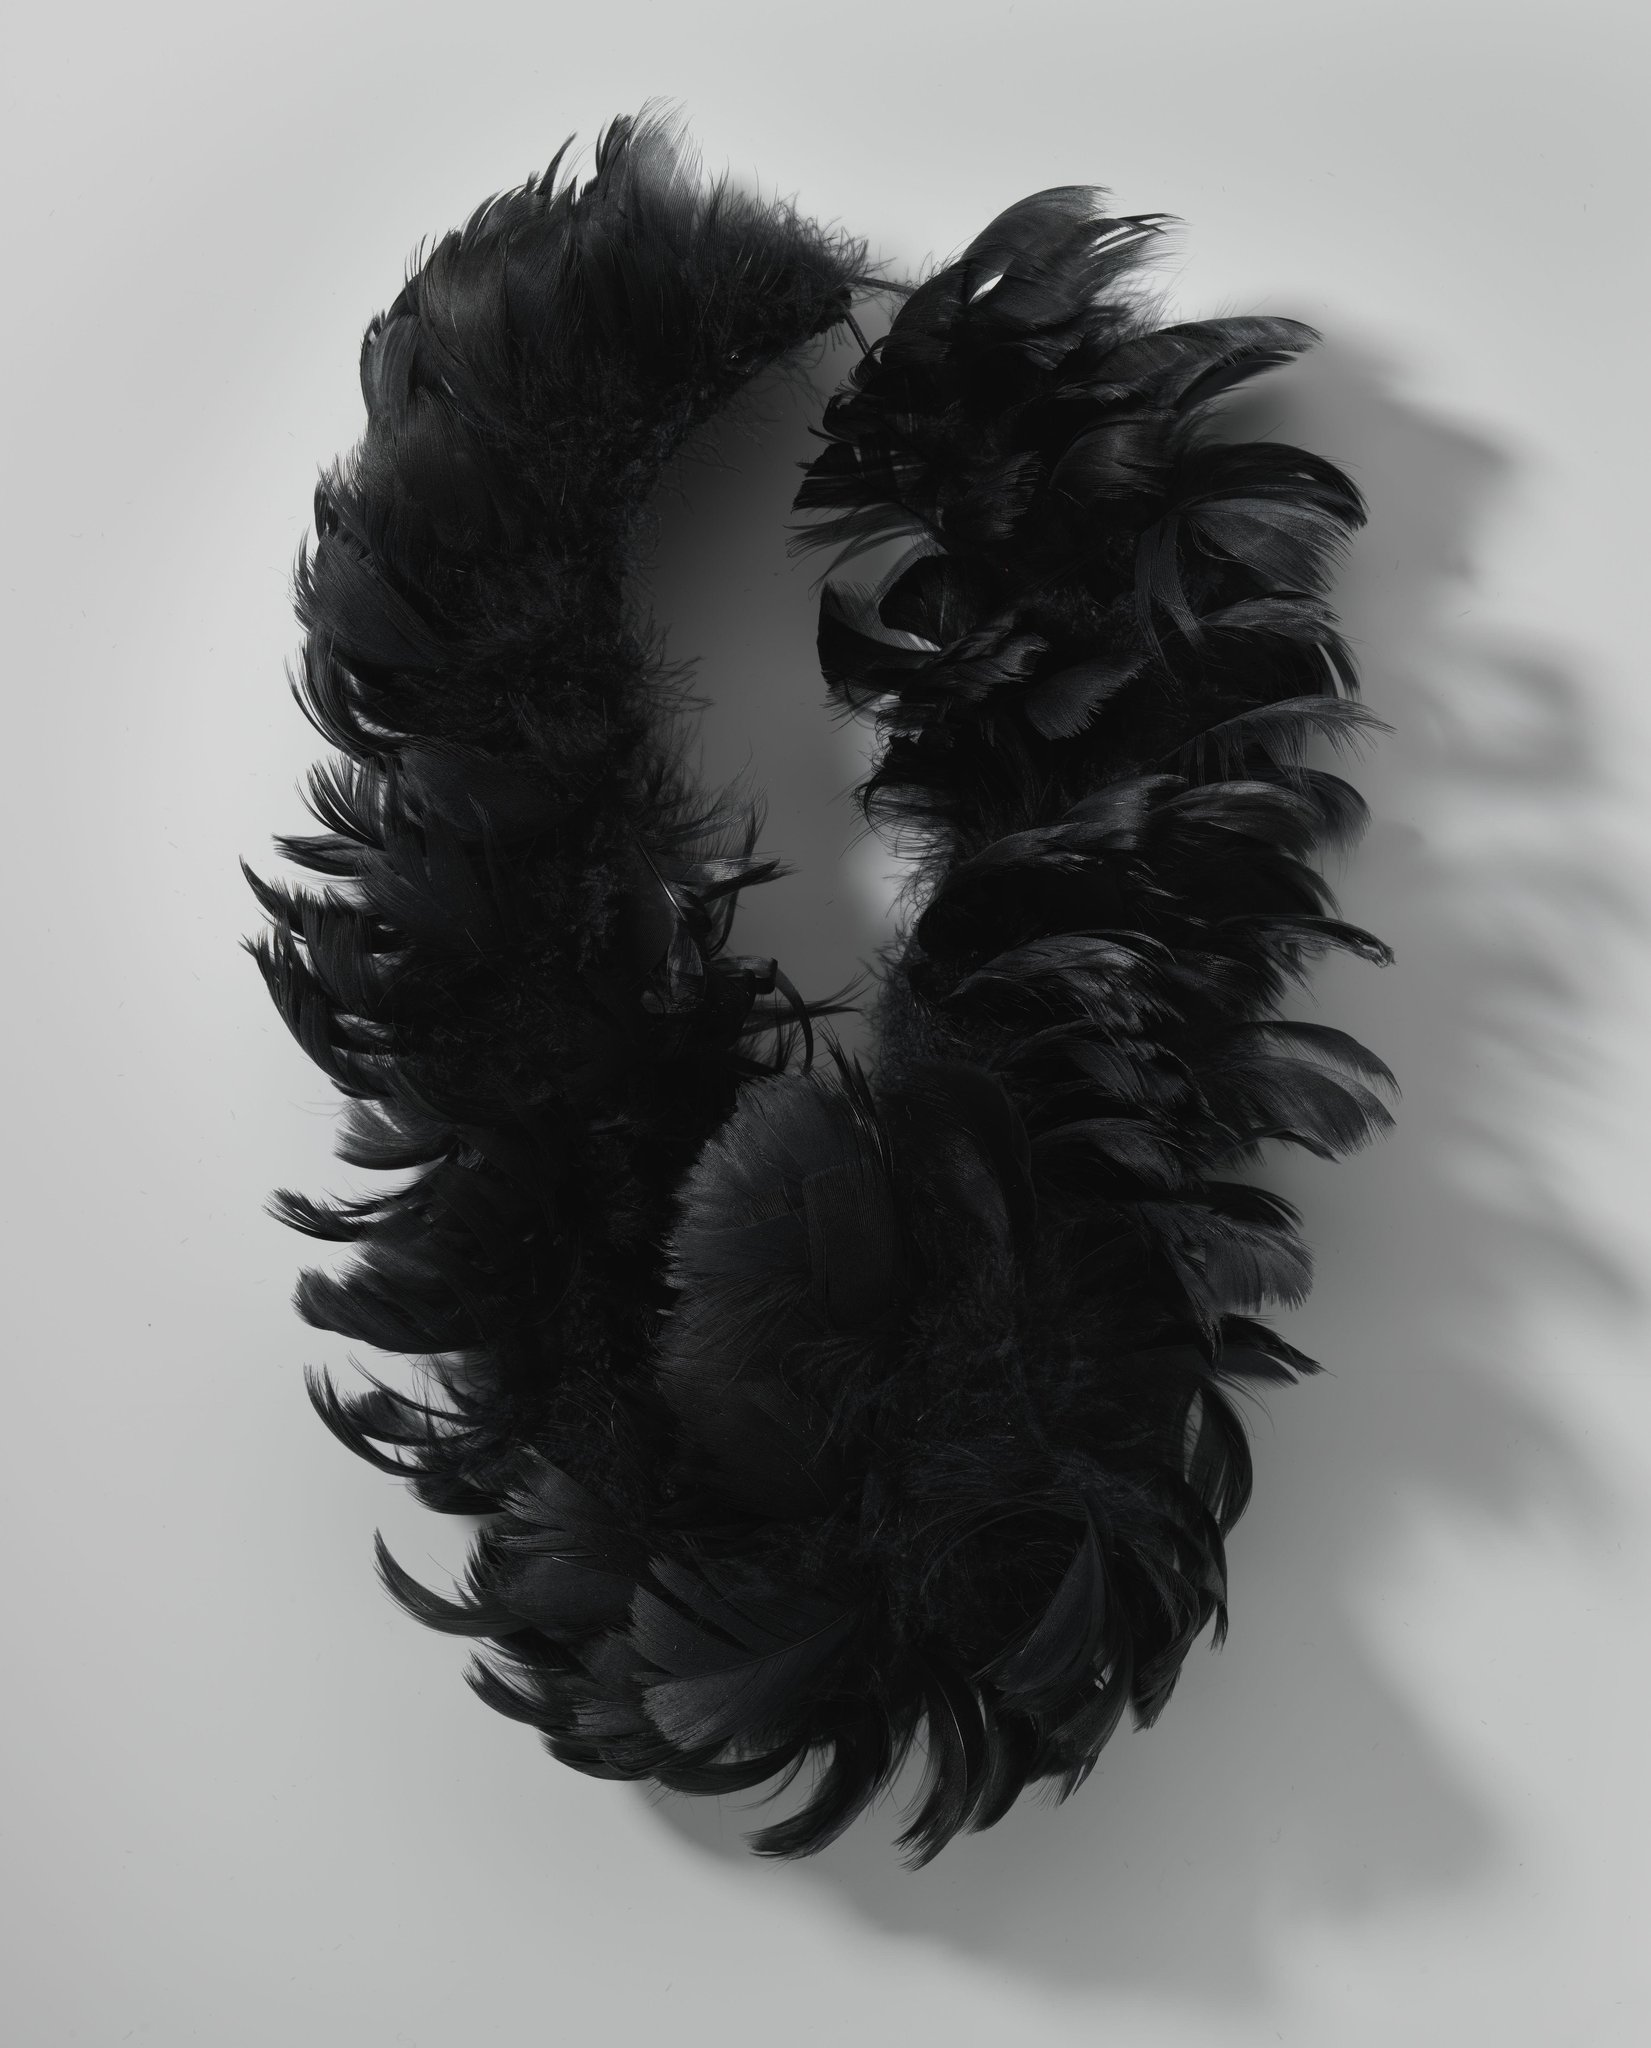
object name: head band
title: Hoofdband van donkerblauwe veren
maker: Anonymous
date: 1950-1985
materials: feather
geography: yugoslavia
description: Hoofdband van donkerblauwe veren, met winkelprijs bevestigd aan de binnenzijde.